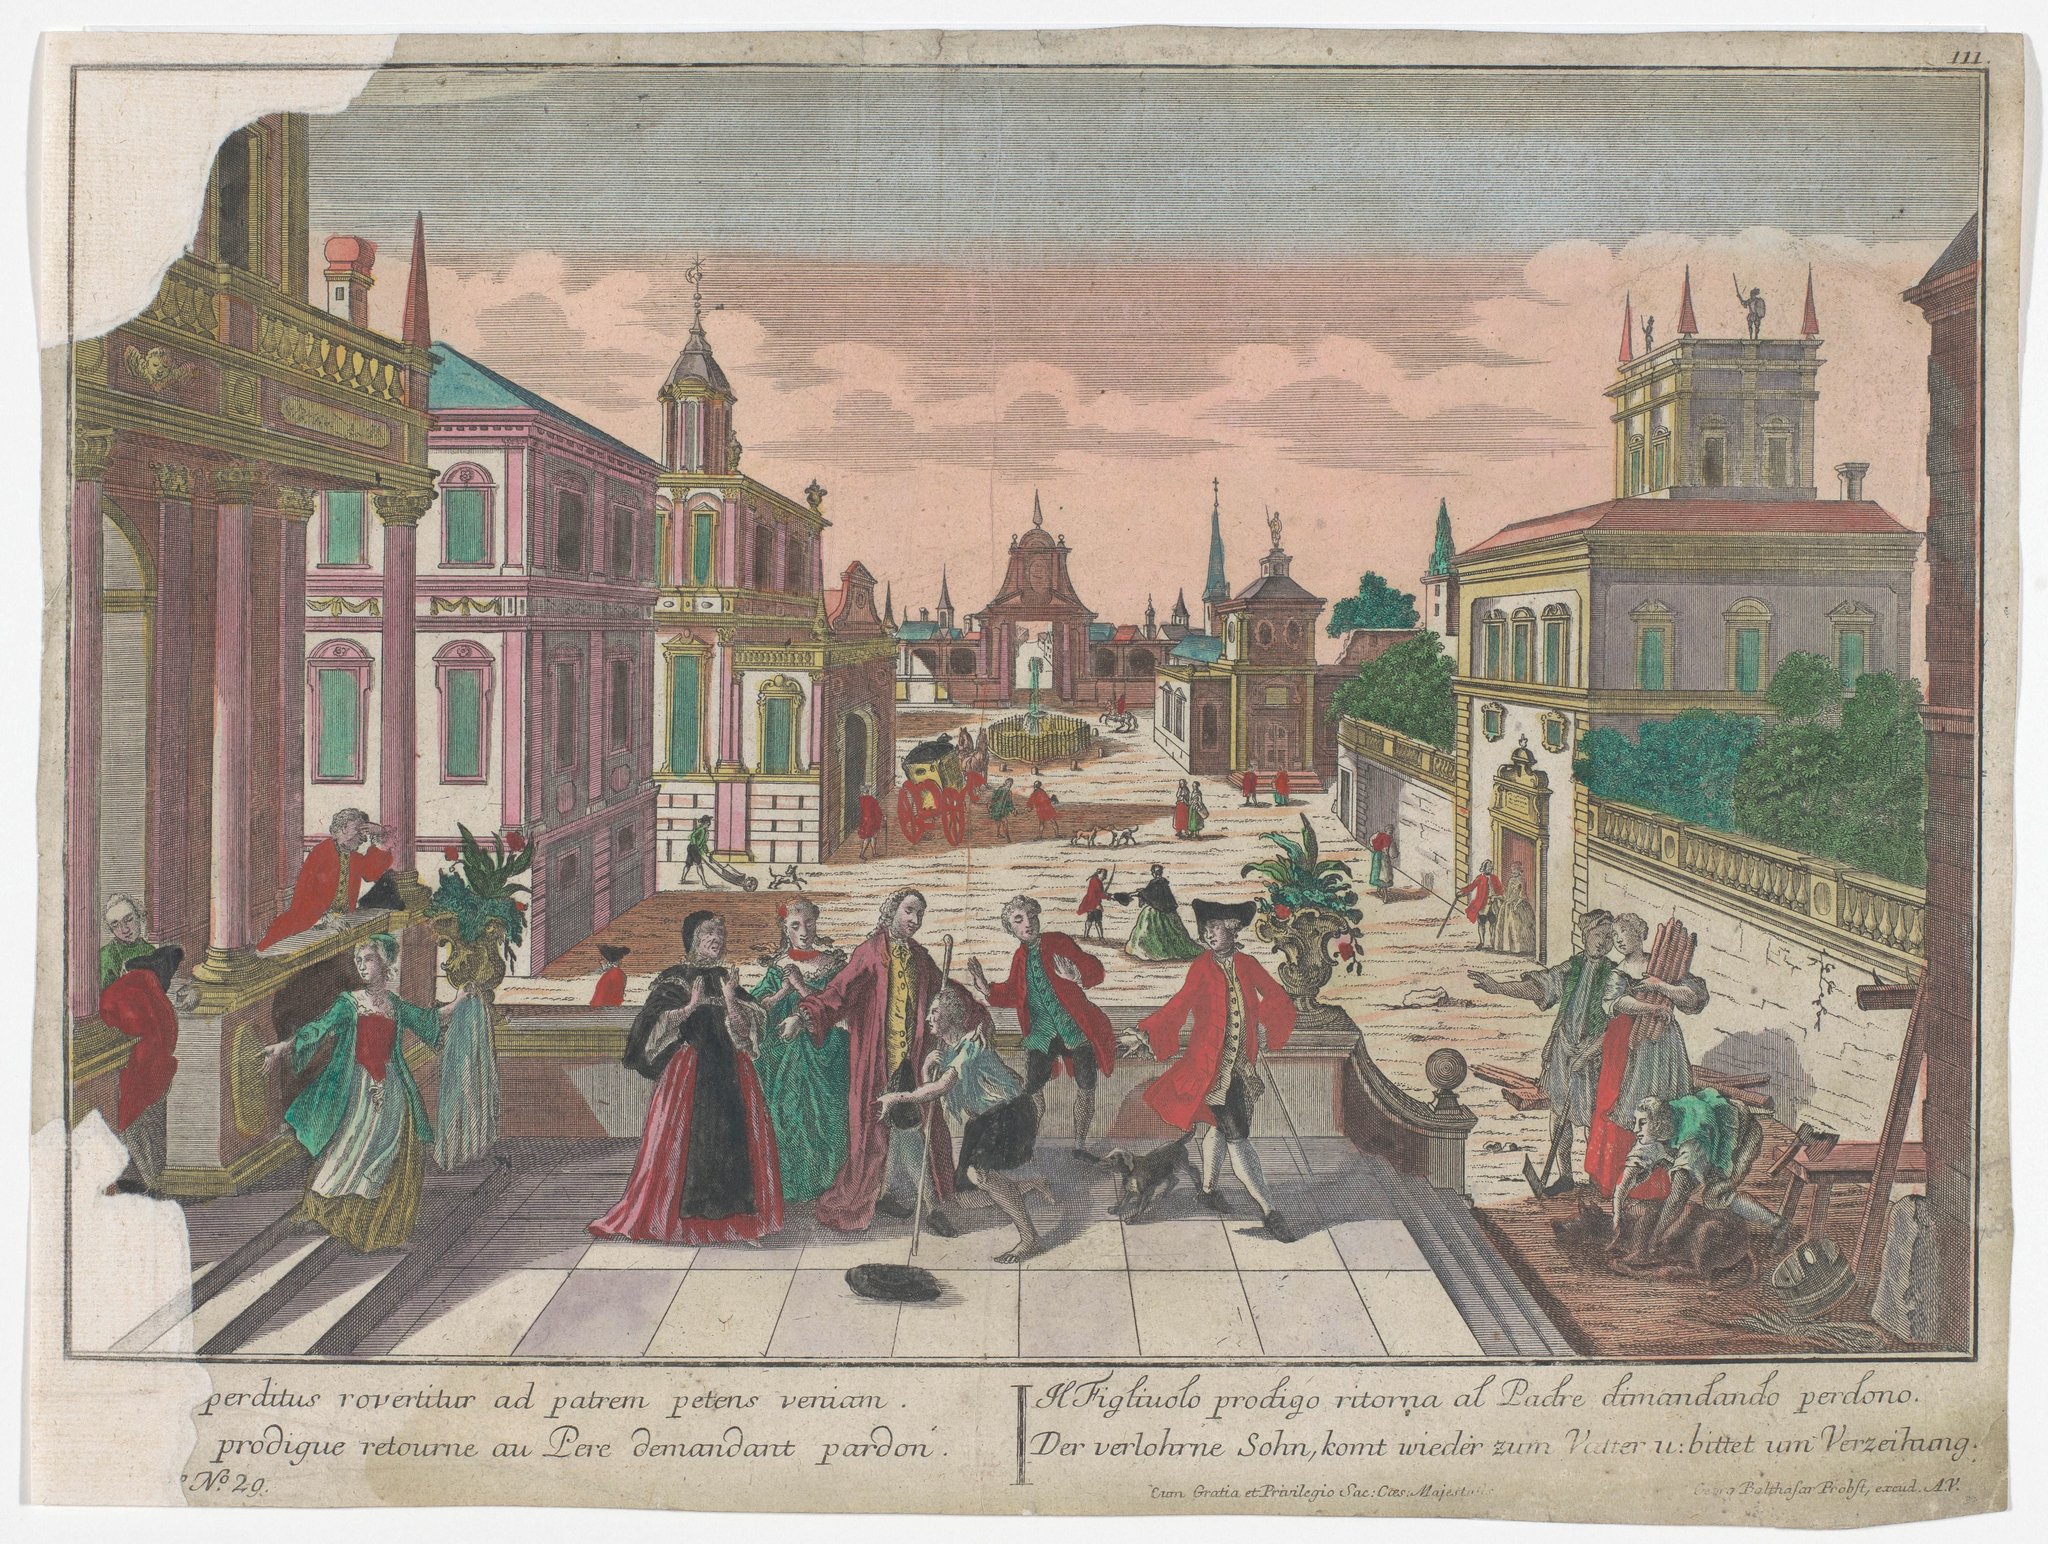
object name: print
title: Gelijkenis van de verloren zoon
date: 1742-1801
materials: paper, watercolor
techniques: brush, etching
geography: augsburg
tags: the prodigal son kneels before his father who takes him in his arms, preparations, e.g. the prodigal son is given new robes; slaughtering of the fatted calf; the elder son objects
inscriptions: collector's mark: Lugt 2228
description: De verloren zoon keert terug naar huis. Hij wordt daar opgewacht door zijn vader, die hem hartelijk verwelkomt. Rechts wordt een kalf geslacht voor een feestmaal om de terugkeer van de zoon te vieren. Rechtsboven genummerd: 111. Linksonder genummerd: 29.